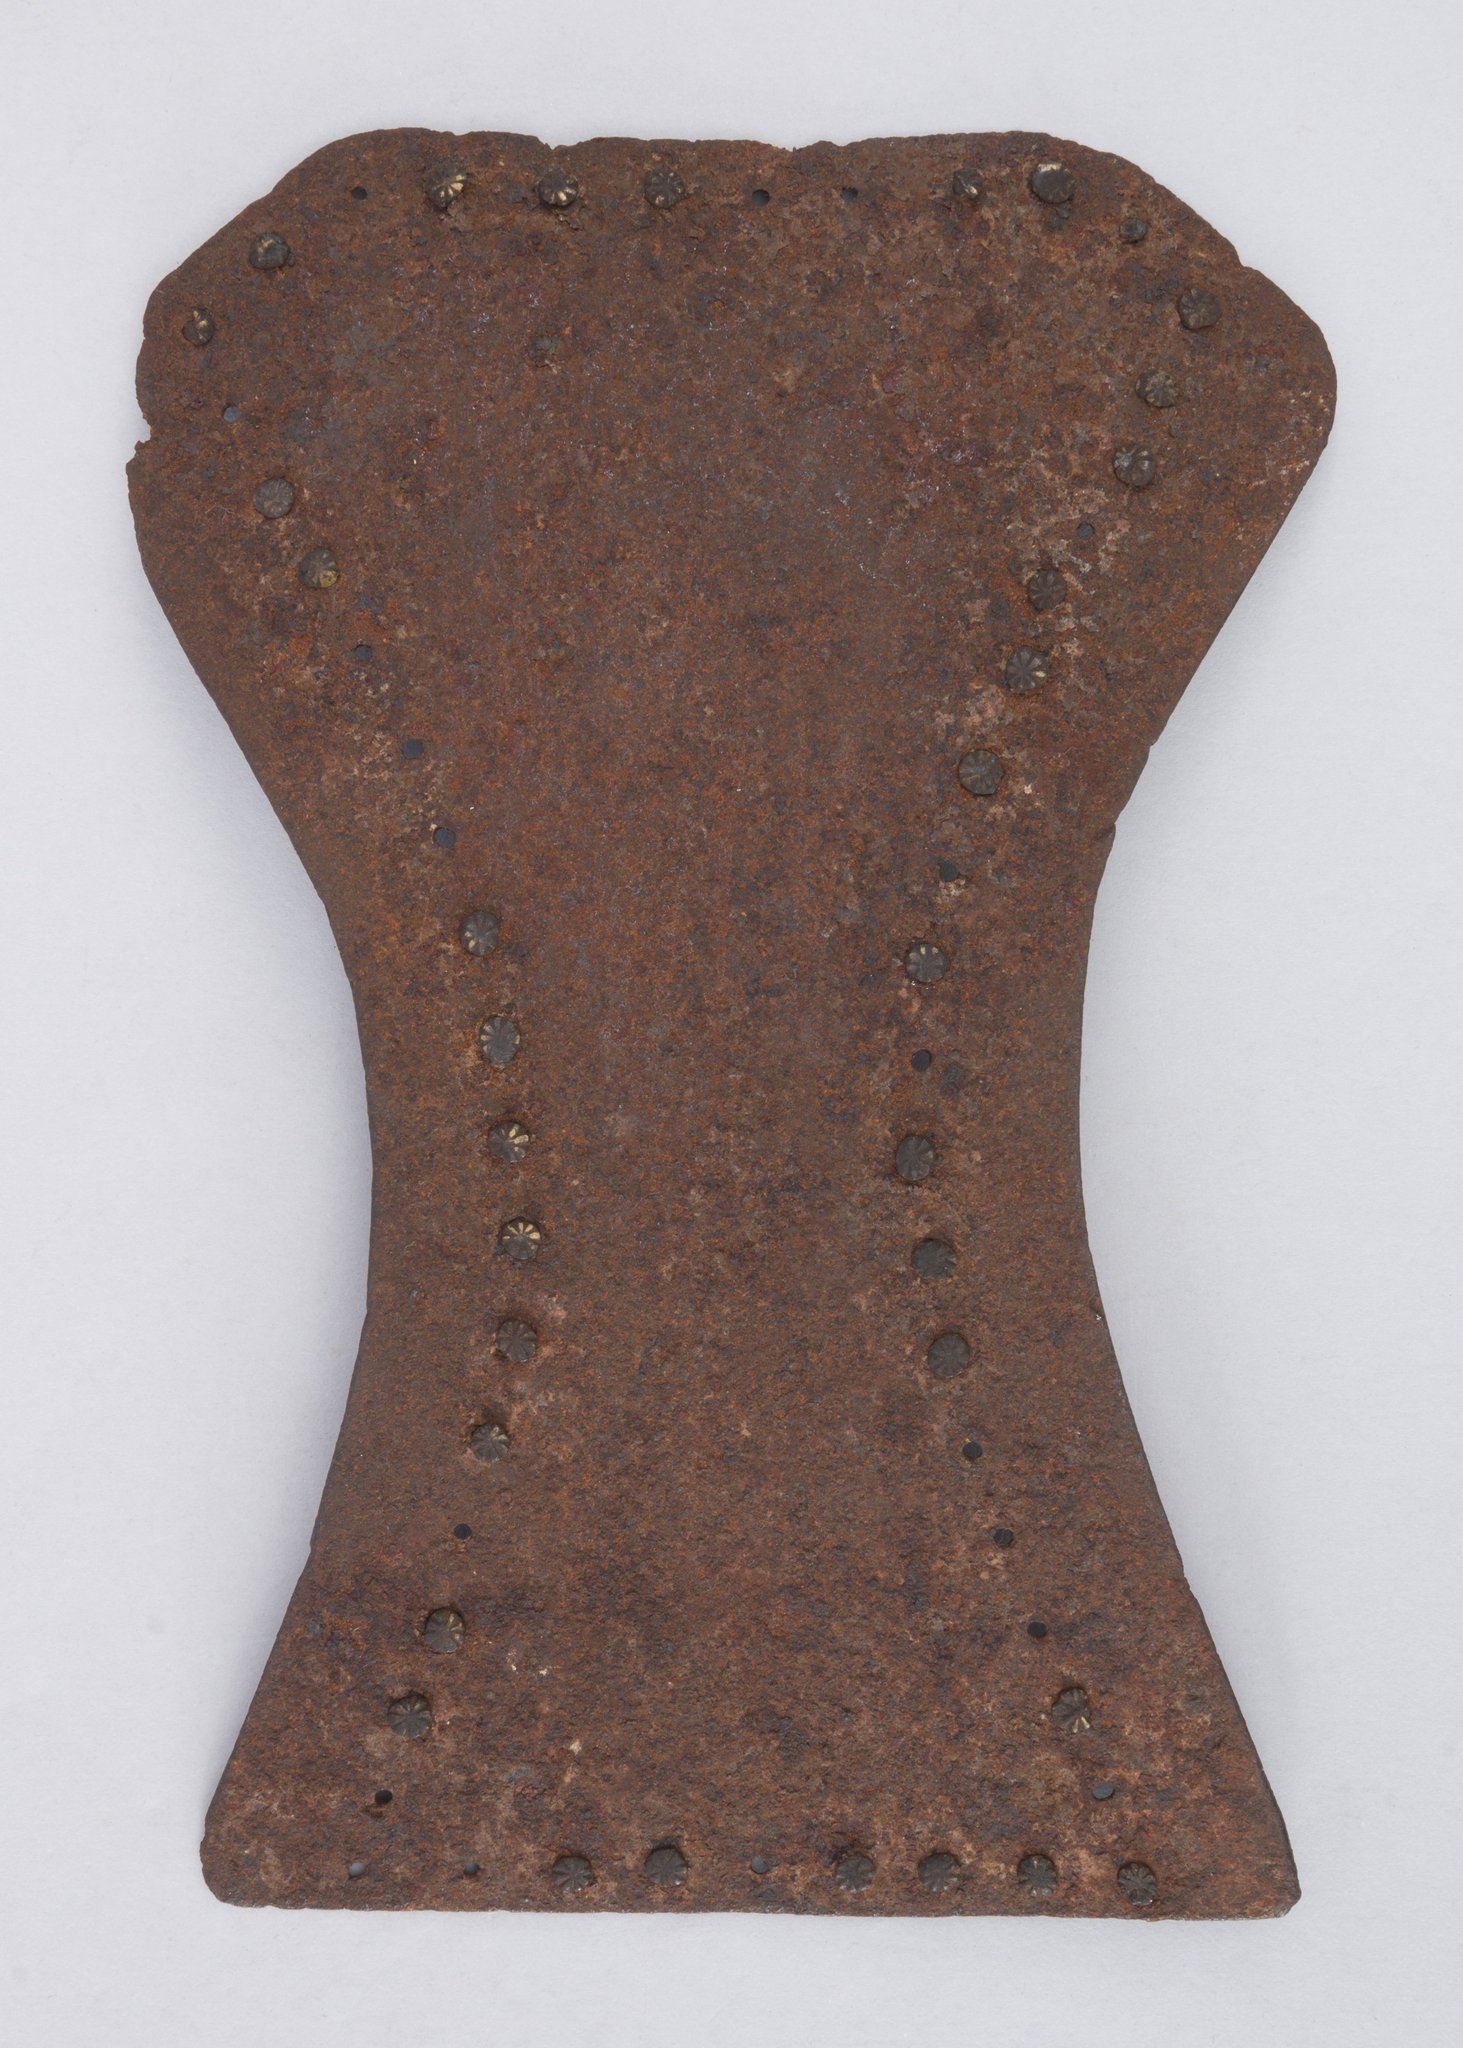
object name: brigandine plate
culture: italian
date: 1400-1450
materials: copper alloy, metal alloy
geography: italy